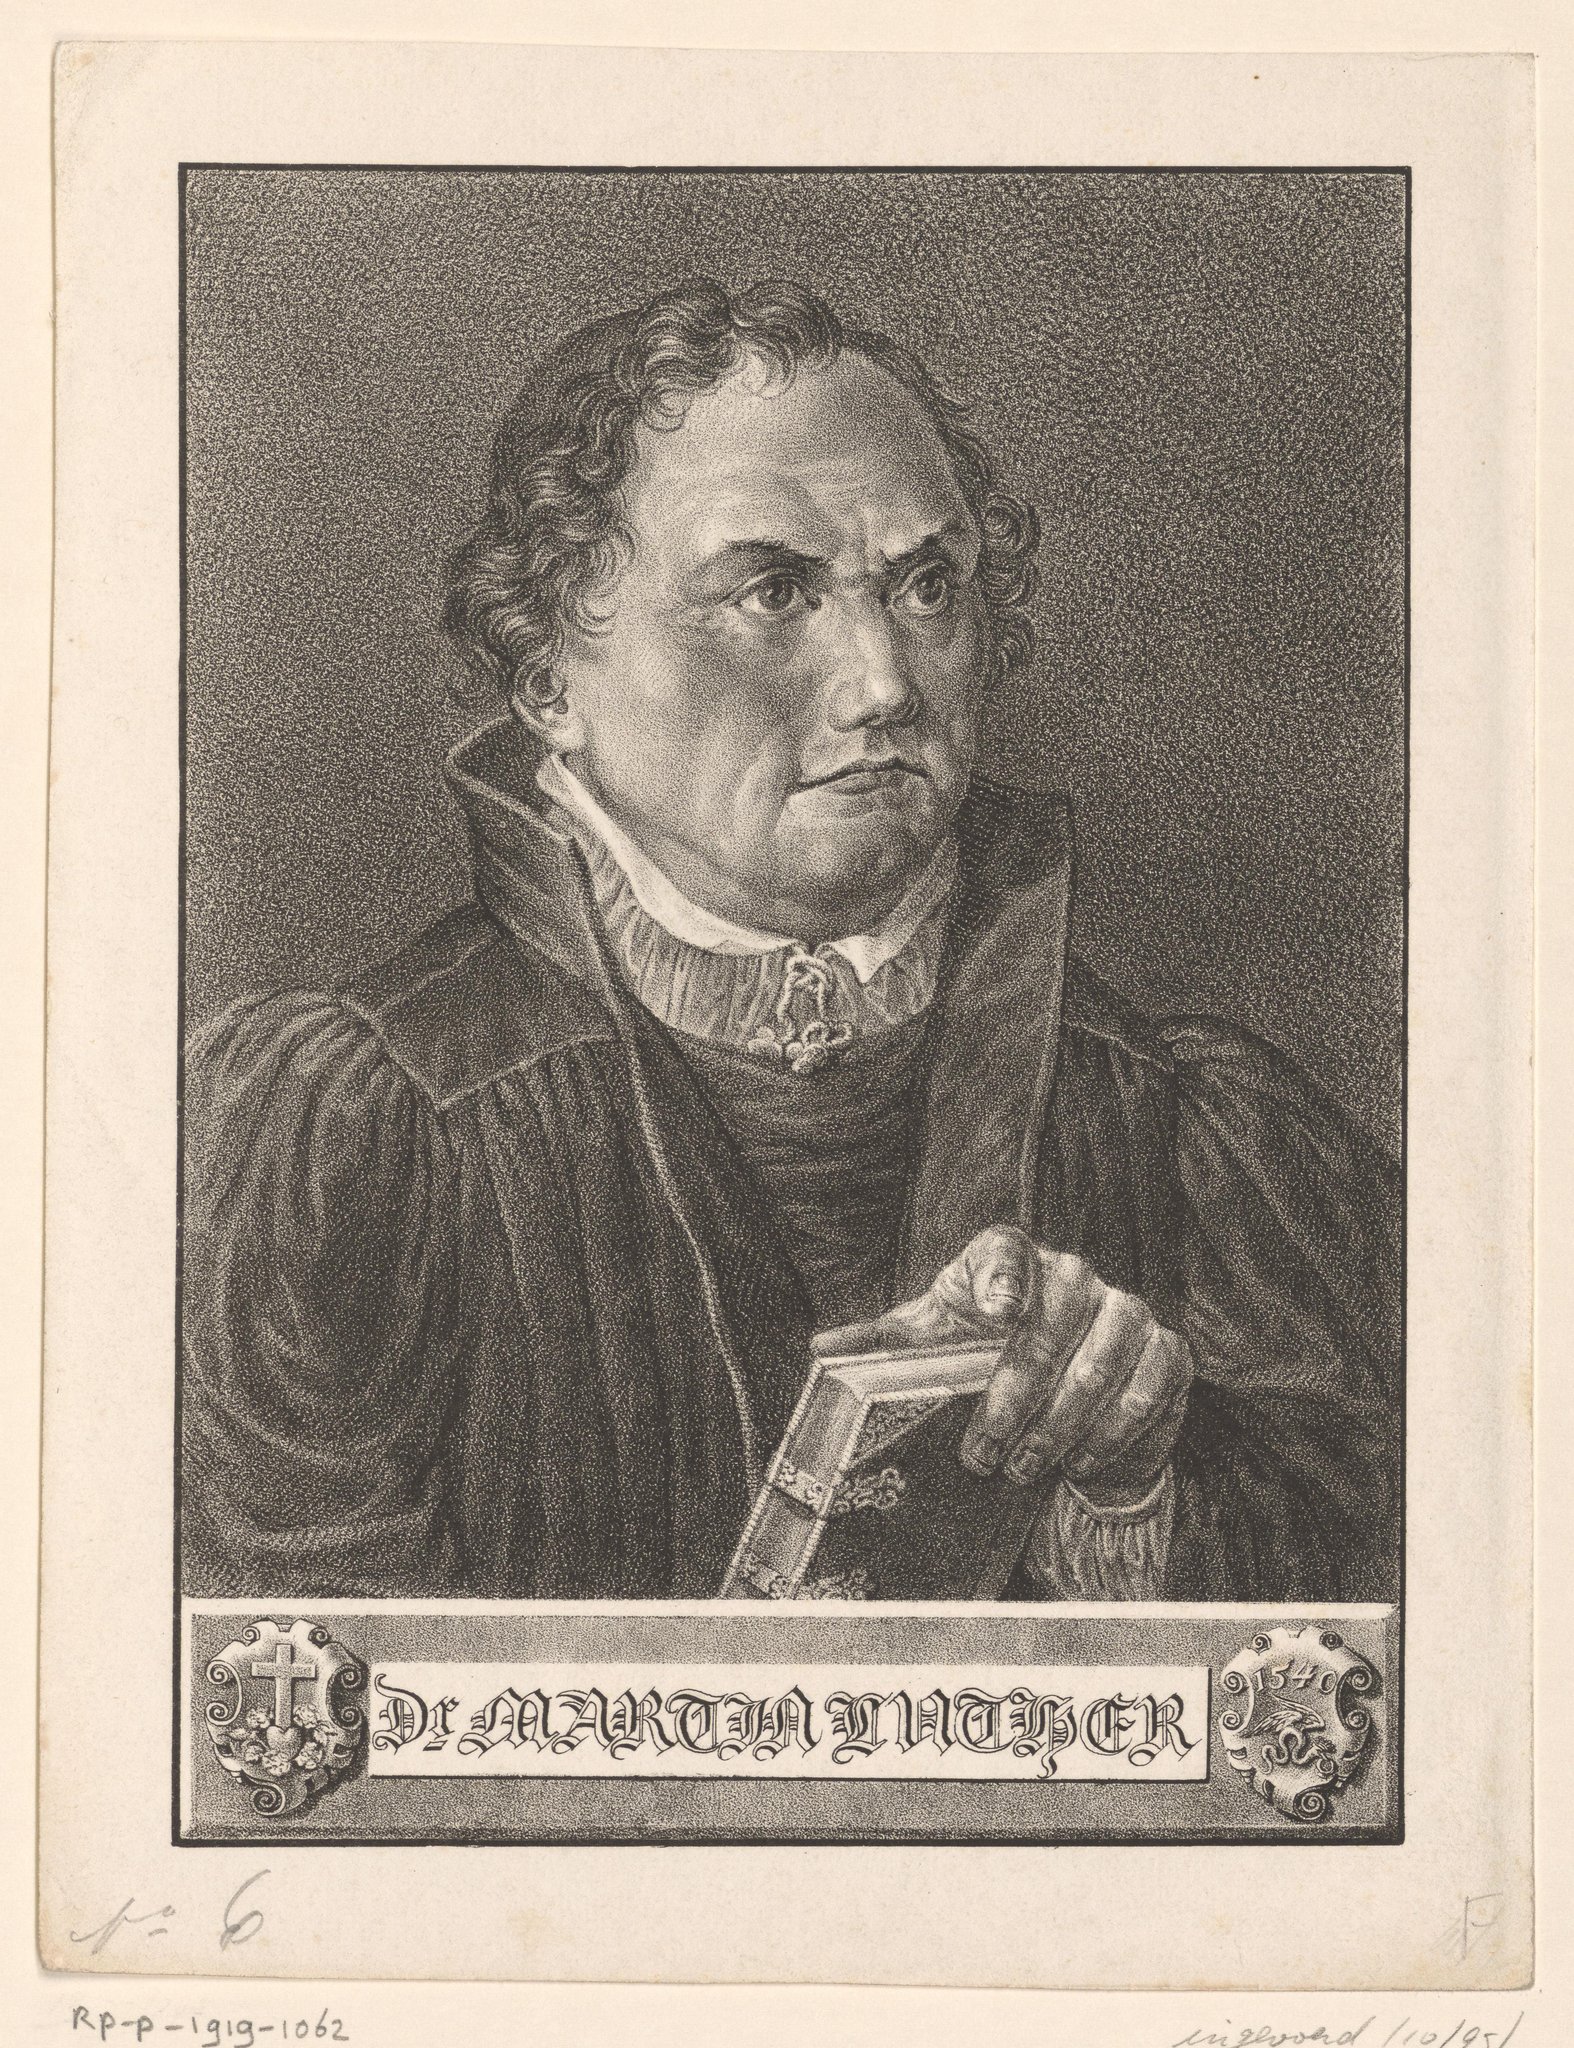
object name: print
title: Portret van Martin Luther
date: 1800-1850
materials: paper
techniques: lithograph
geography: germany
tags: priest, martin luther, theologian, historical persons, book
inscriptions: collector's mark: Lugt 2228, number: ‘No. 6’